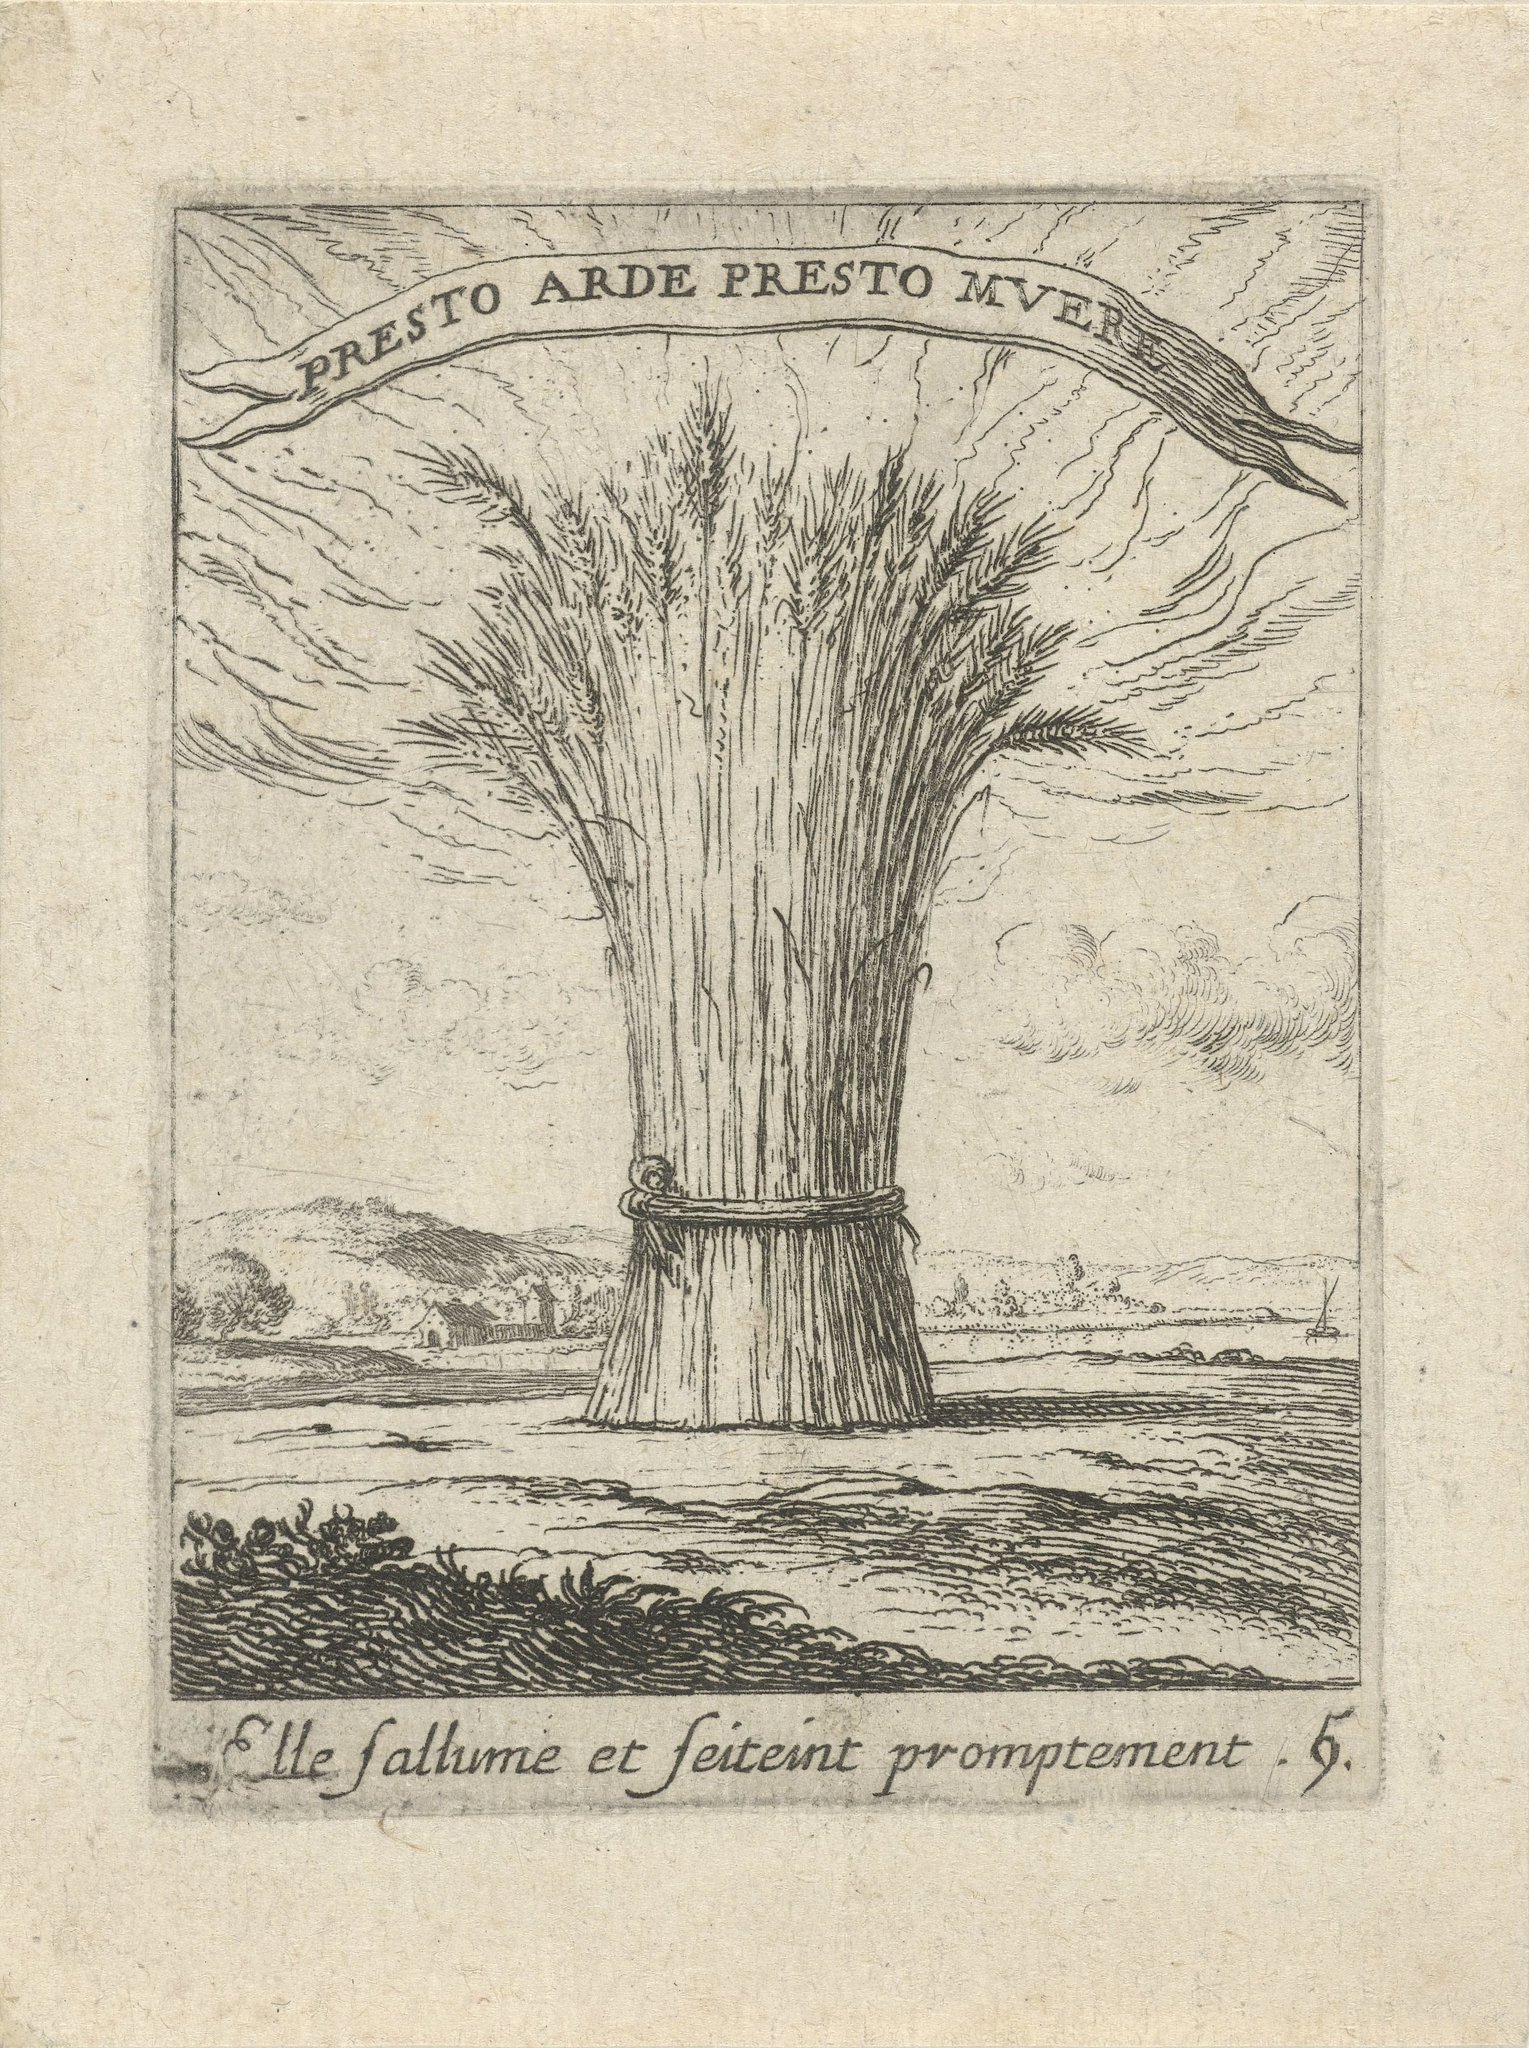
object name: print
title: Moraliserende liefdesemblemen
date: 1672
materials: paper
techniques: etching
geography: paris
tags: qualities of love: first series (+ emblematical representation of concept)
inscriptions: collector's mark: Lugt 2166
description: Een landschap met een reusachtige, vlammende schoof koren. Op een banderol een devies in Latijn en een onderschrift in Frans, beide over de liefde.